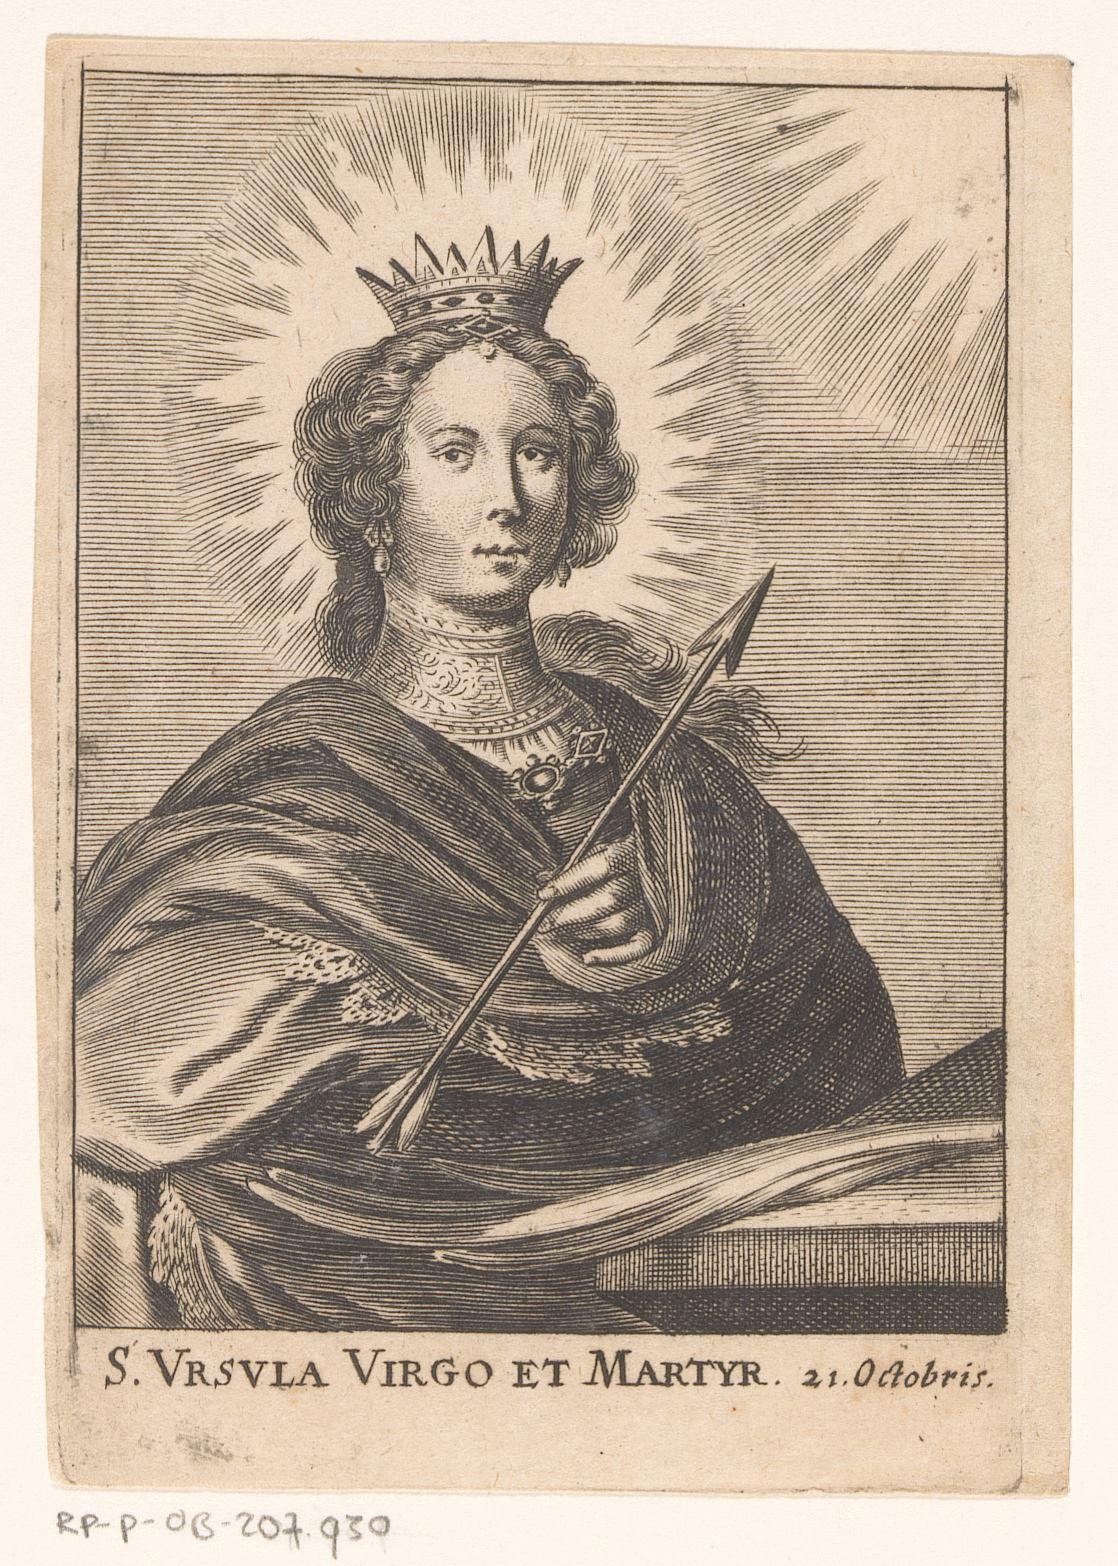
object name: print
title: S. Ursula Virgo et Martyr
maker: Anonymous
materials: paper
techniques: engraving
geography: antwerp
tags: the virgin martyr ursula of cologne; possible attributes: arrow, banner with red cross, cloak of ermine, crown, ship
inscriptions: collector's mark: Lugt 2228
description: Deze prent maakt deel uit van een reeks van onbekende omvang met kopieën naar prenten door Pieter de Jode I naar ontwerp van Jan van Mechelen. De prenten door Pieter de Jode werden gebruikt voor de publicatie: Rosweyde, Heribertus. Het leven der HH. Maeghden. Antwerpen: Jan Cnobbaert, 1626.